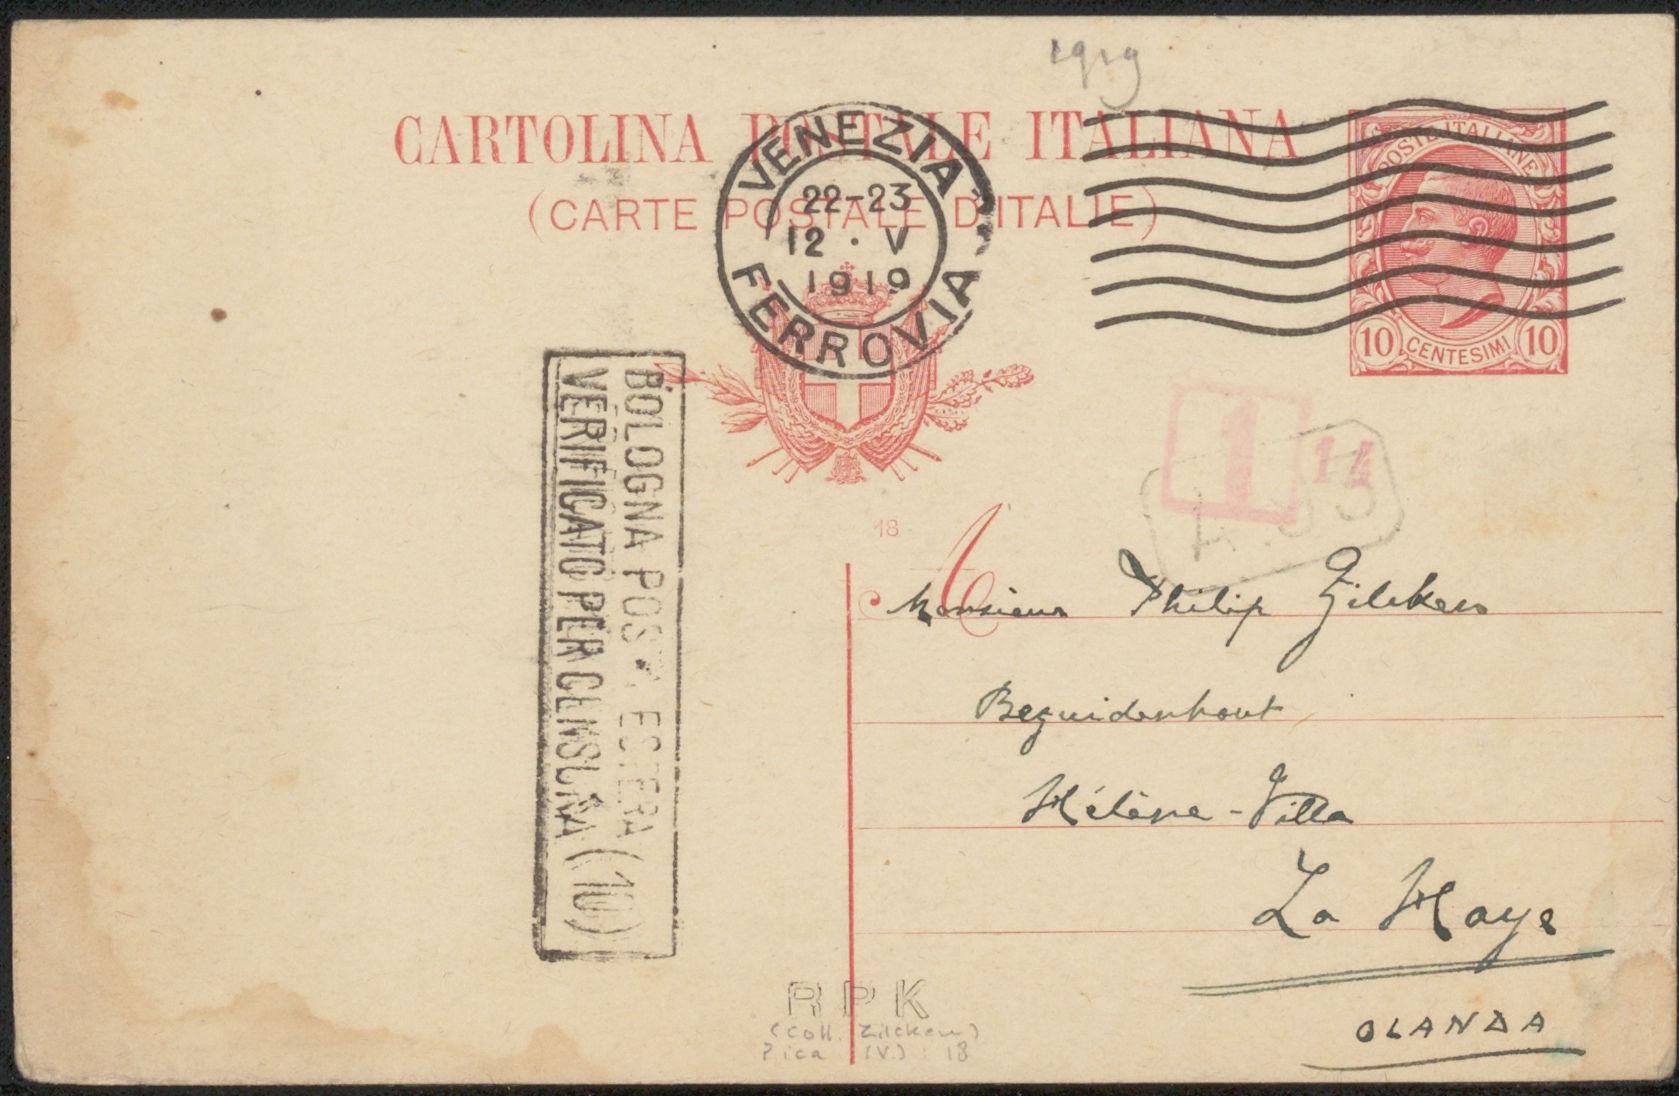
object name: postcard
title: Briefkaart aan Philip Zilcken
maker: vittorio pica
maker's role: criticus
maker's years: 1864-1930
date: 1919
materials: cardboard, ink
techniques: pen, writing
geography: venice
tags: carel nicolaas storm van 's-gravesande, print maker, jan toorop, the hague, draughtsman, philip zilcken, venice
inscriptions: collector's mark: ‘RPK’